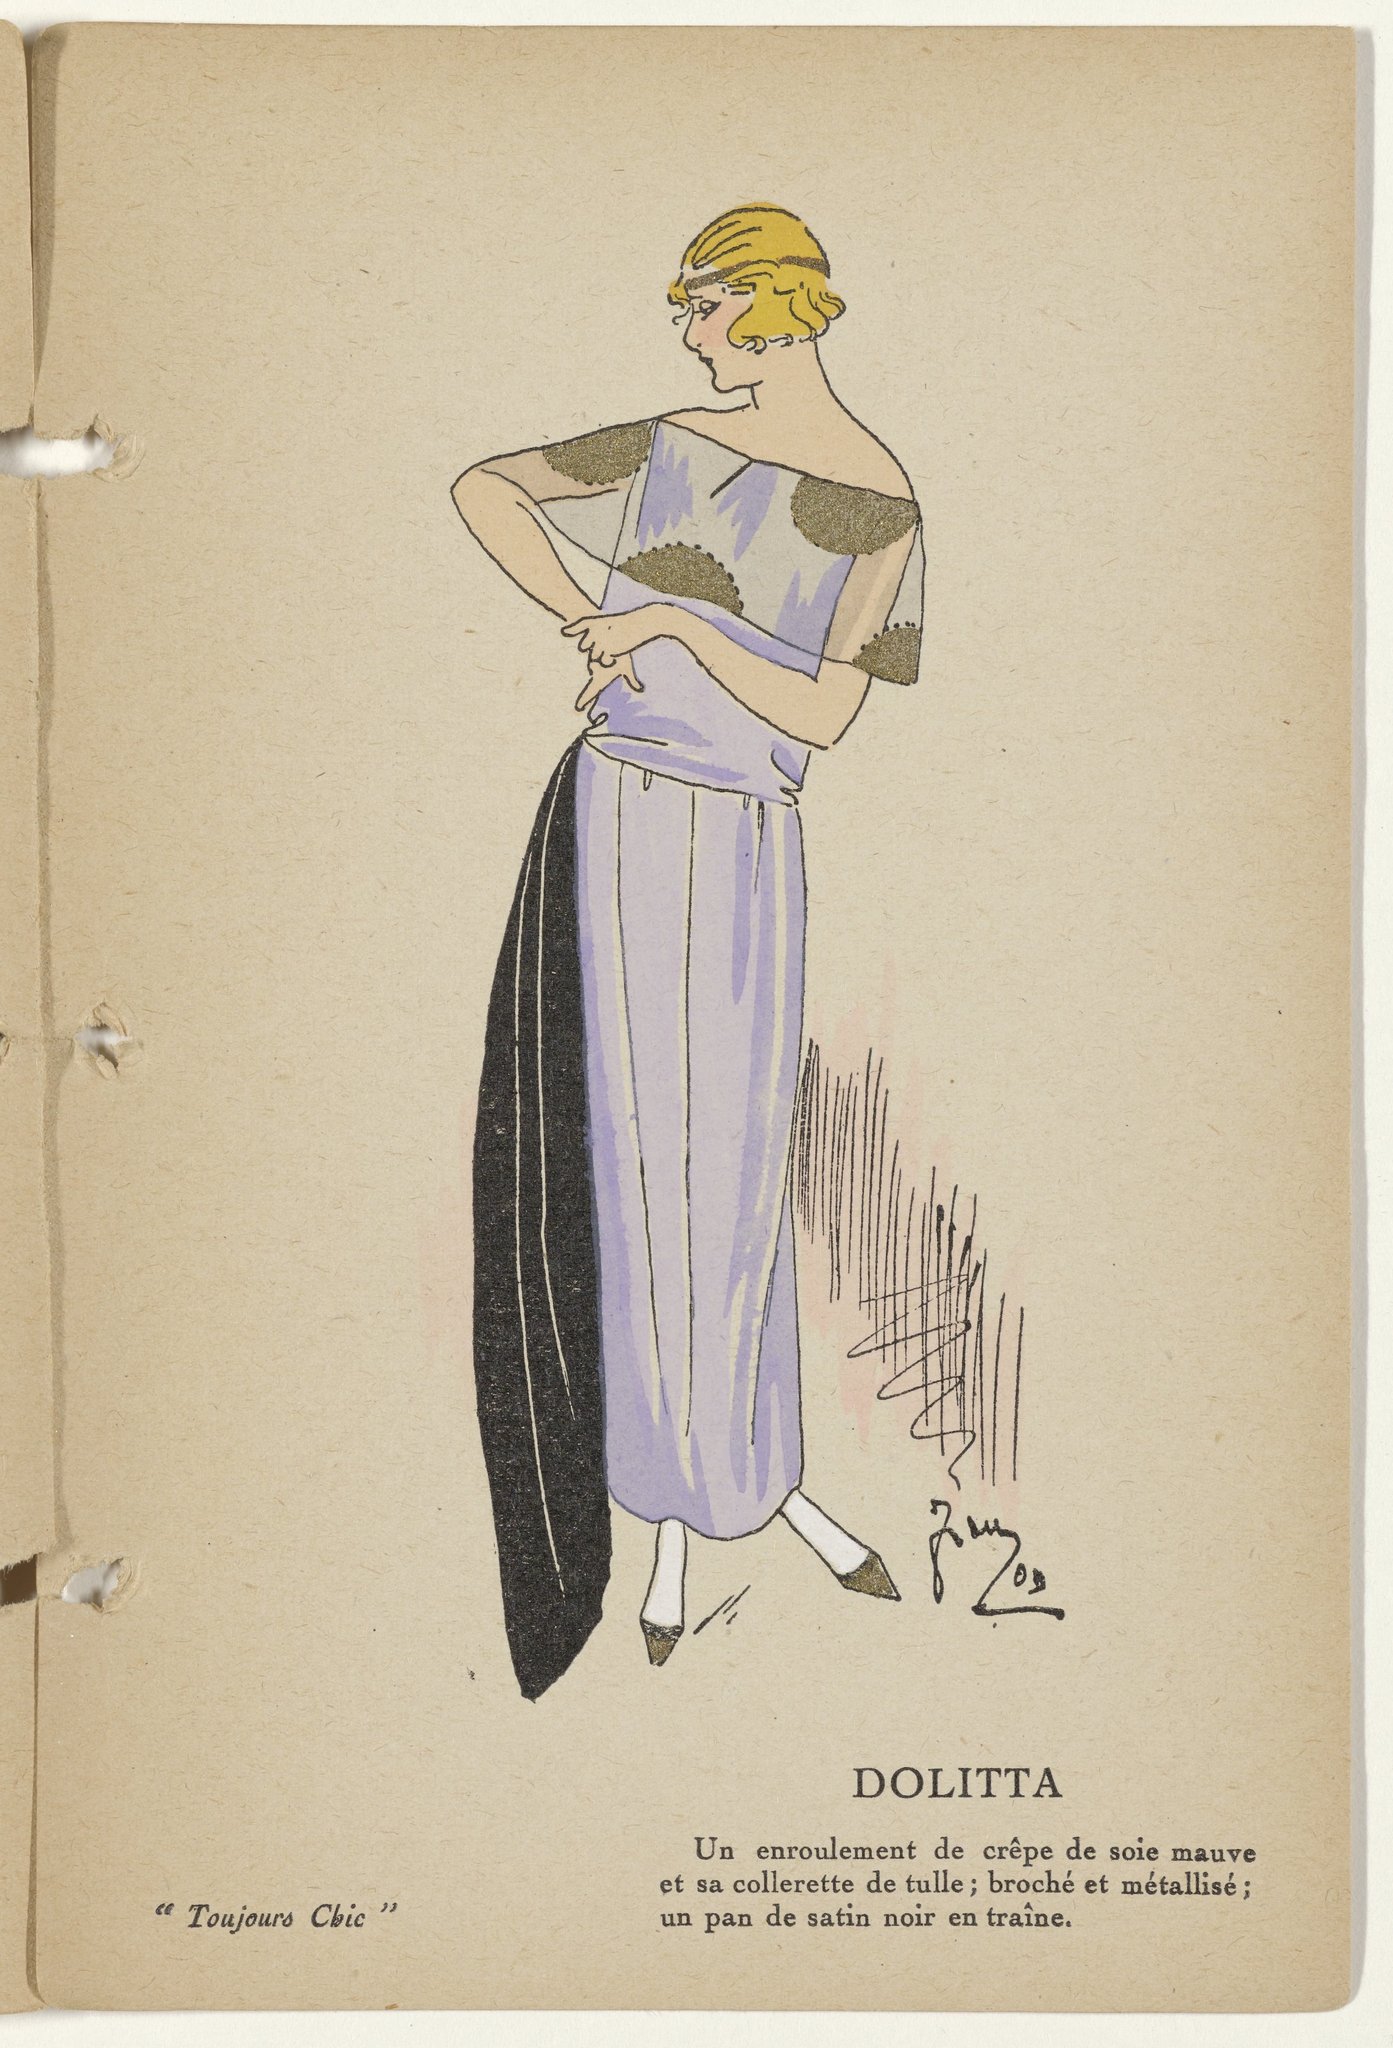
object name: fashion print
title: Toujours Chic Les Deshabillés, Hiver 1921-1922: Dolitta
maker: g-p. joumard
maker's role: publisher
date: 1921-1922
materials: paper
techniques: letterpress printing, pochoir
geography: paris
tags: fashion plates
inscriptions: date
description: Prent uit Catalogus "Toujours Chic" waarin een overzicht van de wintermode 1921-1922.